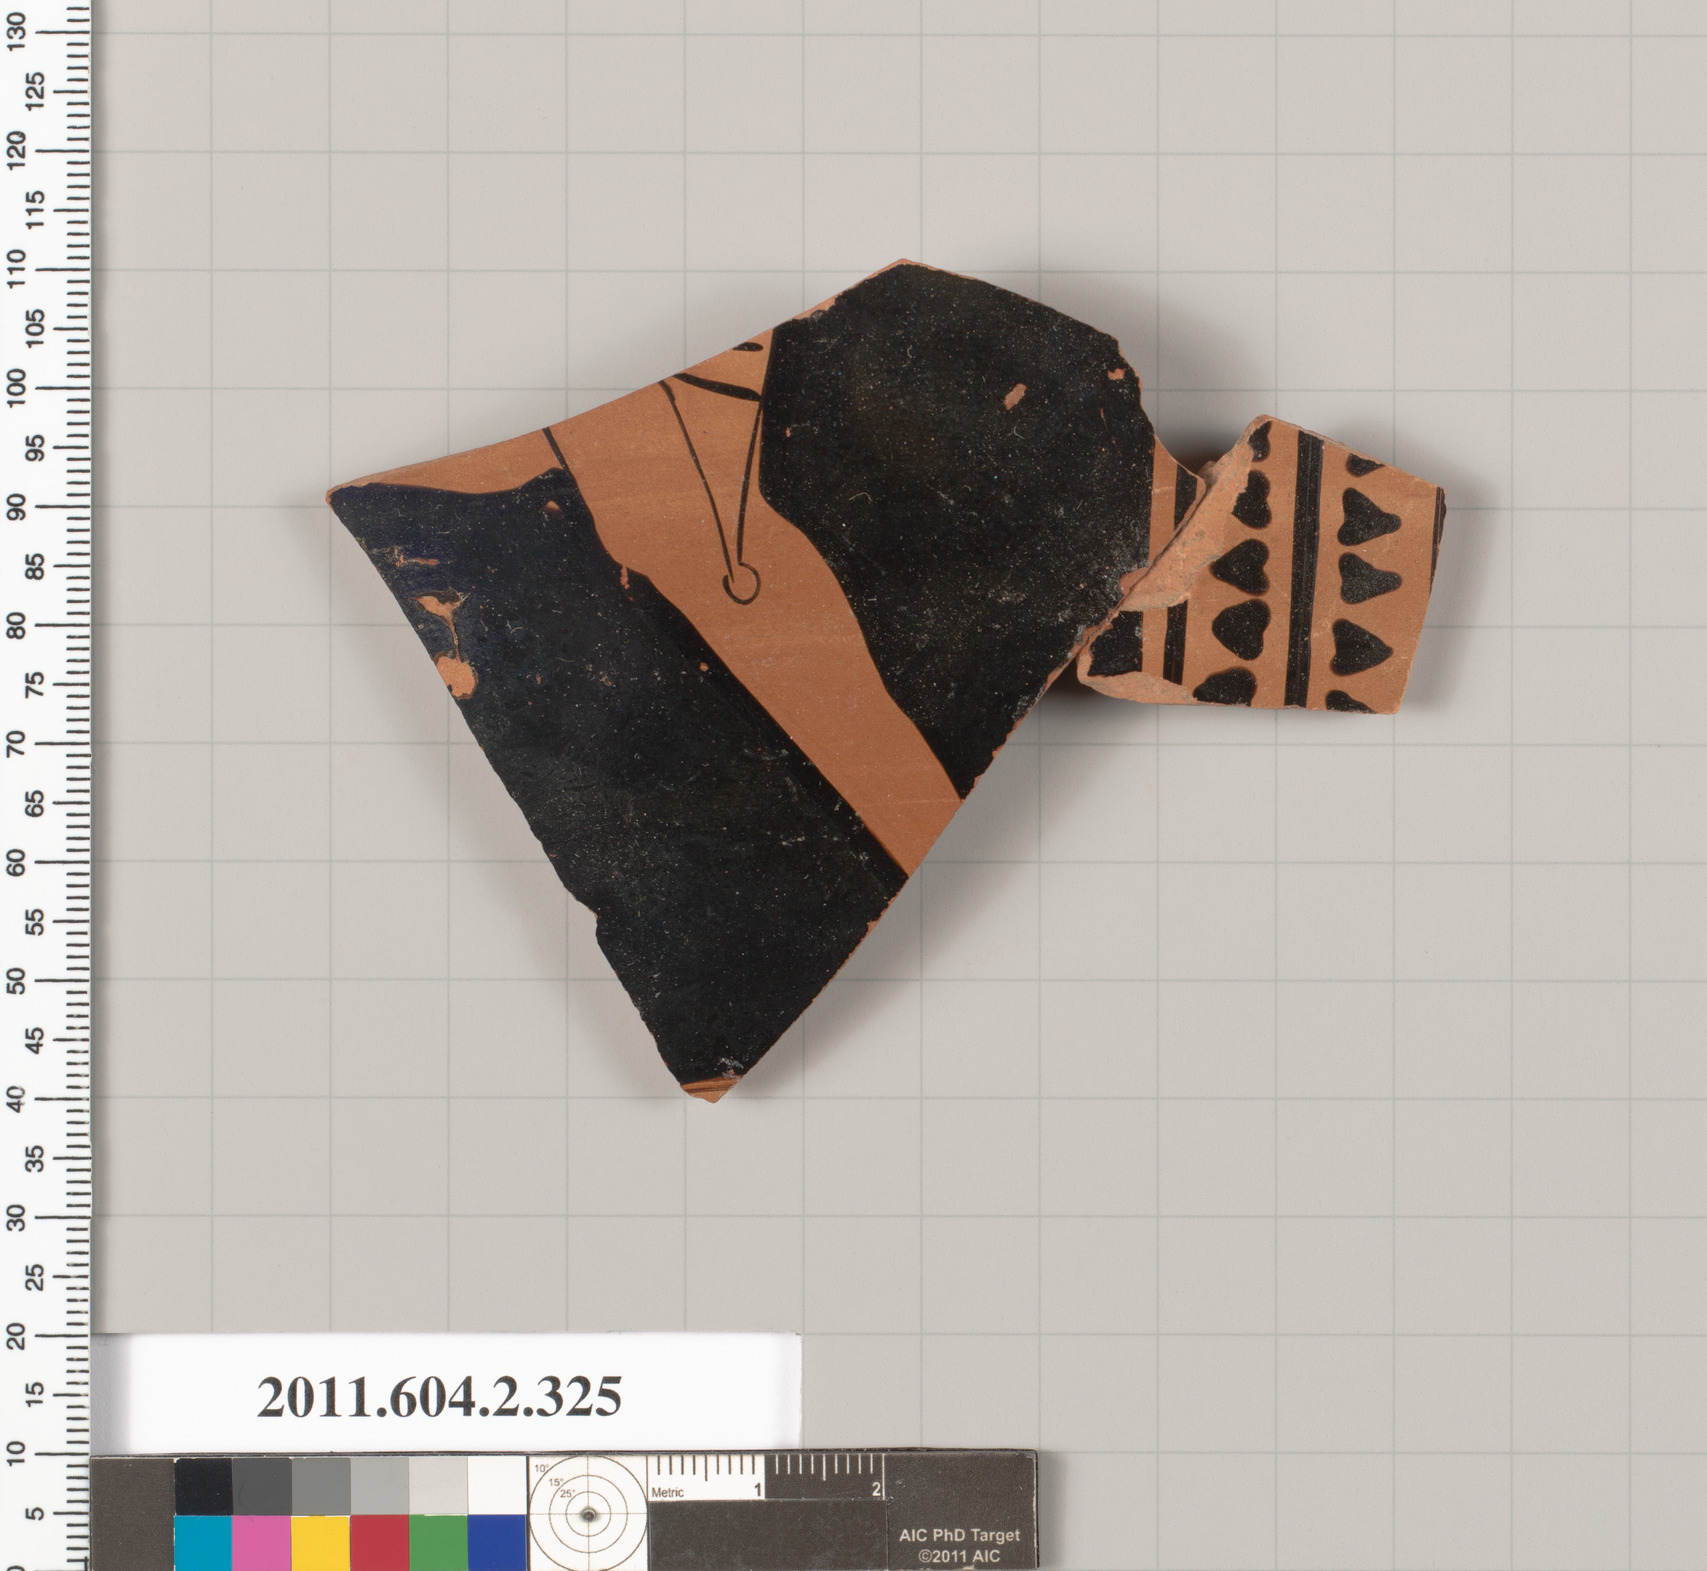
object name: column krater fragment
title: Terracotta fragment of a column-krater (bowl for mixing wine and water)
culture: greek, attic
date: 460-440 BCE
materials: terracotta